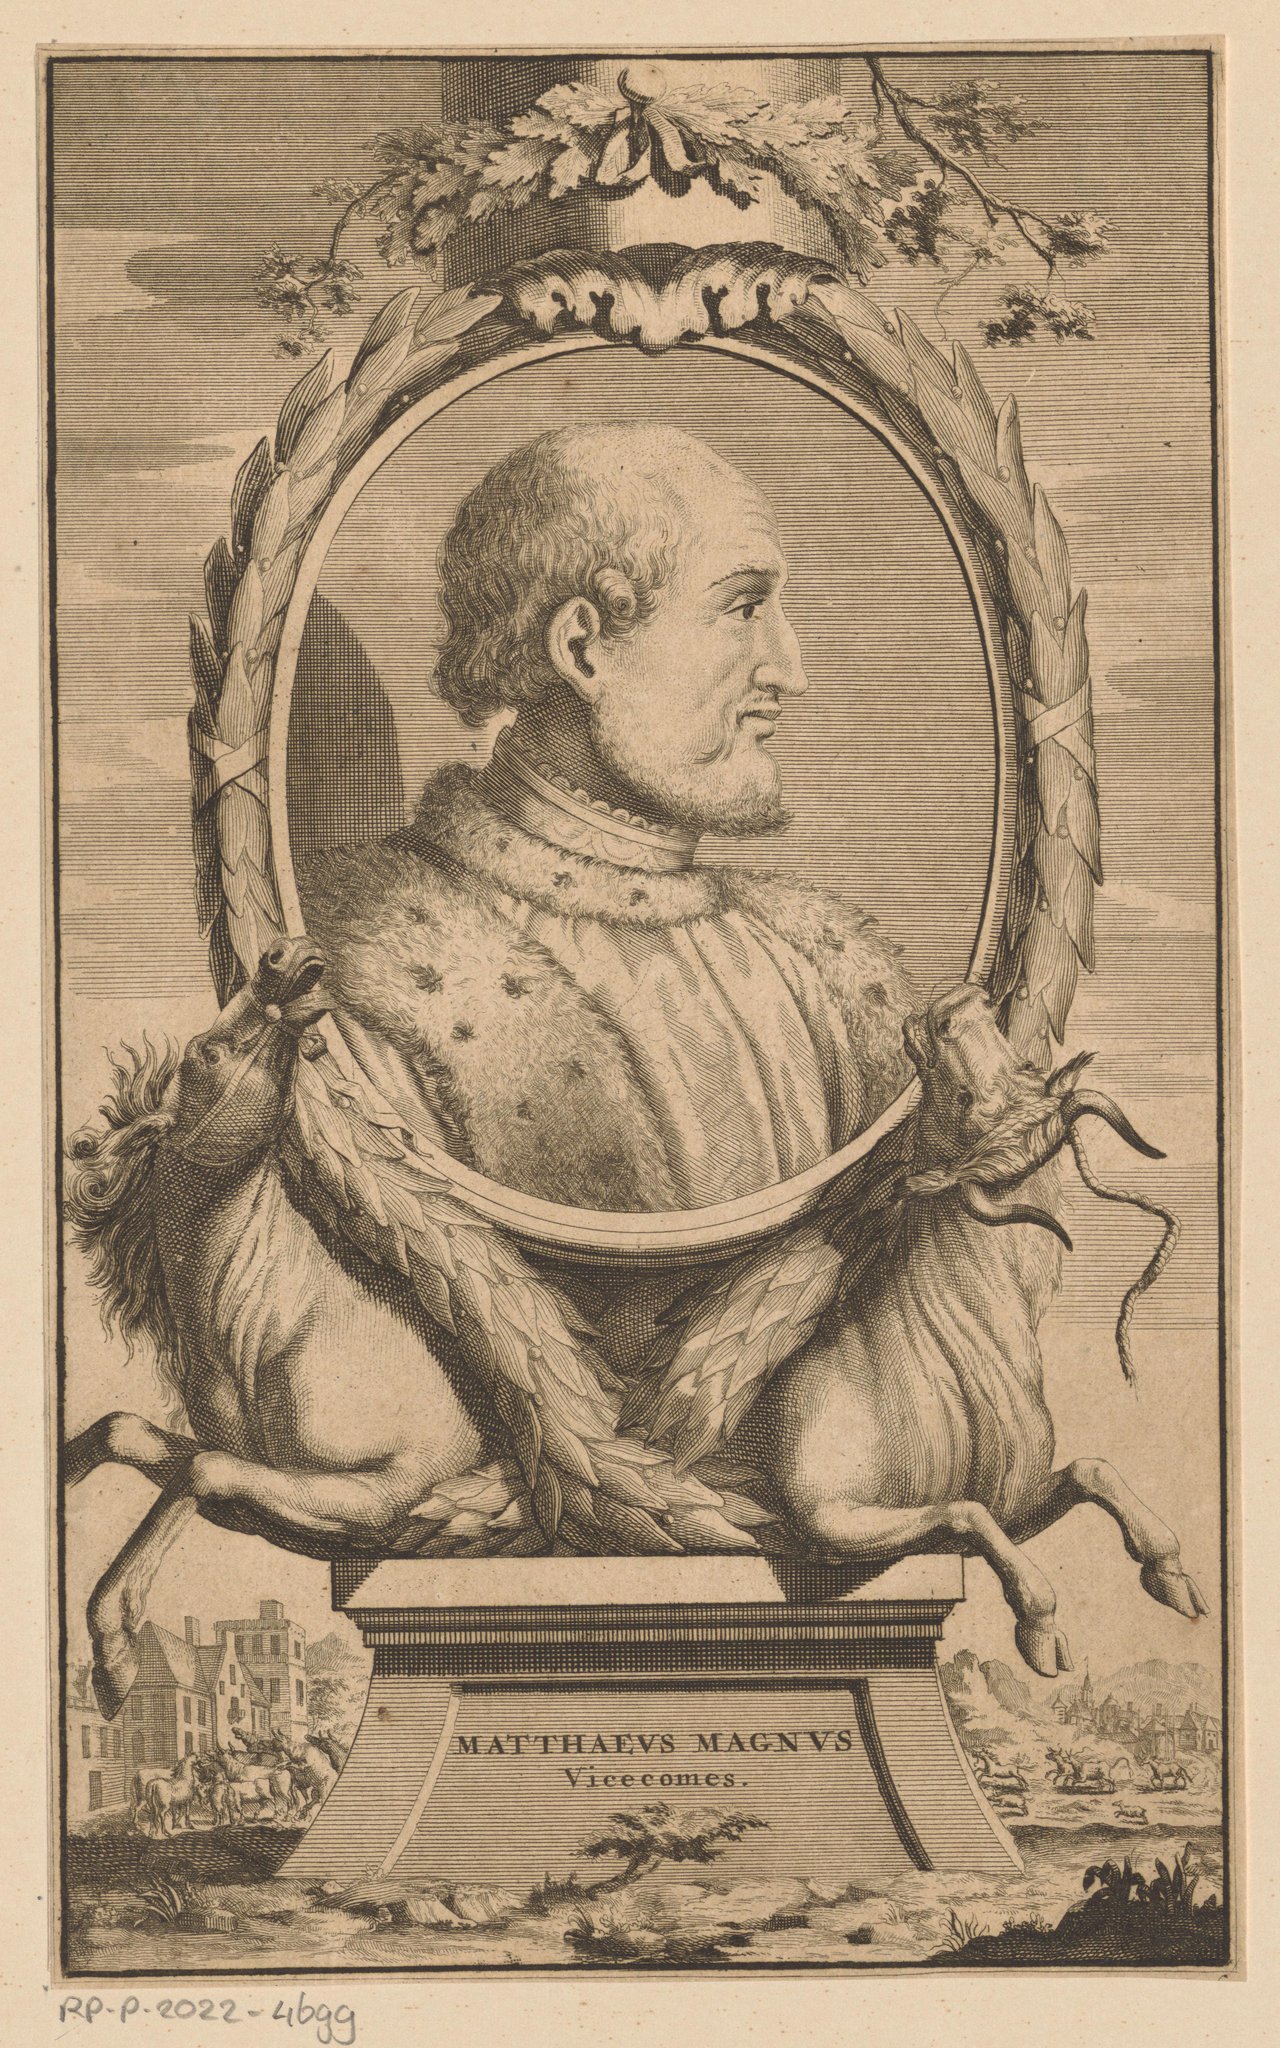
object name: print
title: Principum et illustrium quorundam virorum qui in Europa alibique terrarum quam fama quam eruditione celebres fuerunt, verae imagines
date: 1710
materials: paper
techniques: engraving, etching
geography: leiden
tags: historical persons, ruler, sovereign, horse, ox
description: Prent waarschijnlijk uit: Principum et illustrium quorundam virorum qui in Europa alibique terrarum quam fama quam eruditione celebres fuerunt, verae imagines. Leiden: Pieter van der Aa, [ca. 1710]. Prent mogelijk ook gebruikt in: Graevius, Johannes Georg. Thesaurus Antiquitatum et Historiarum Italiae (...). Leiden: Pieter van der Aa, 1722, dl. 1-6. Eerdere staat gebruikt in de editie uit 1704.